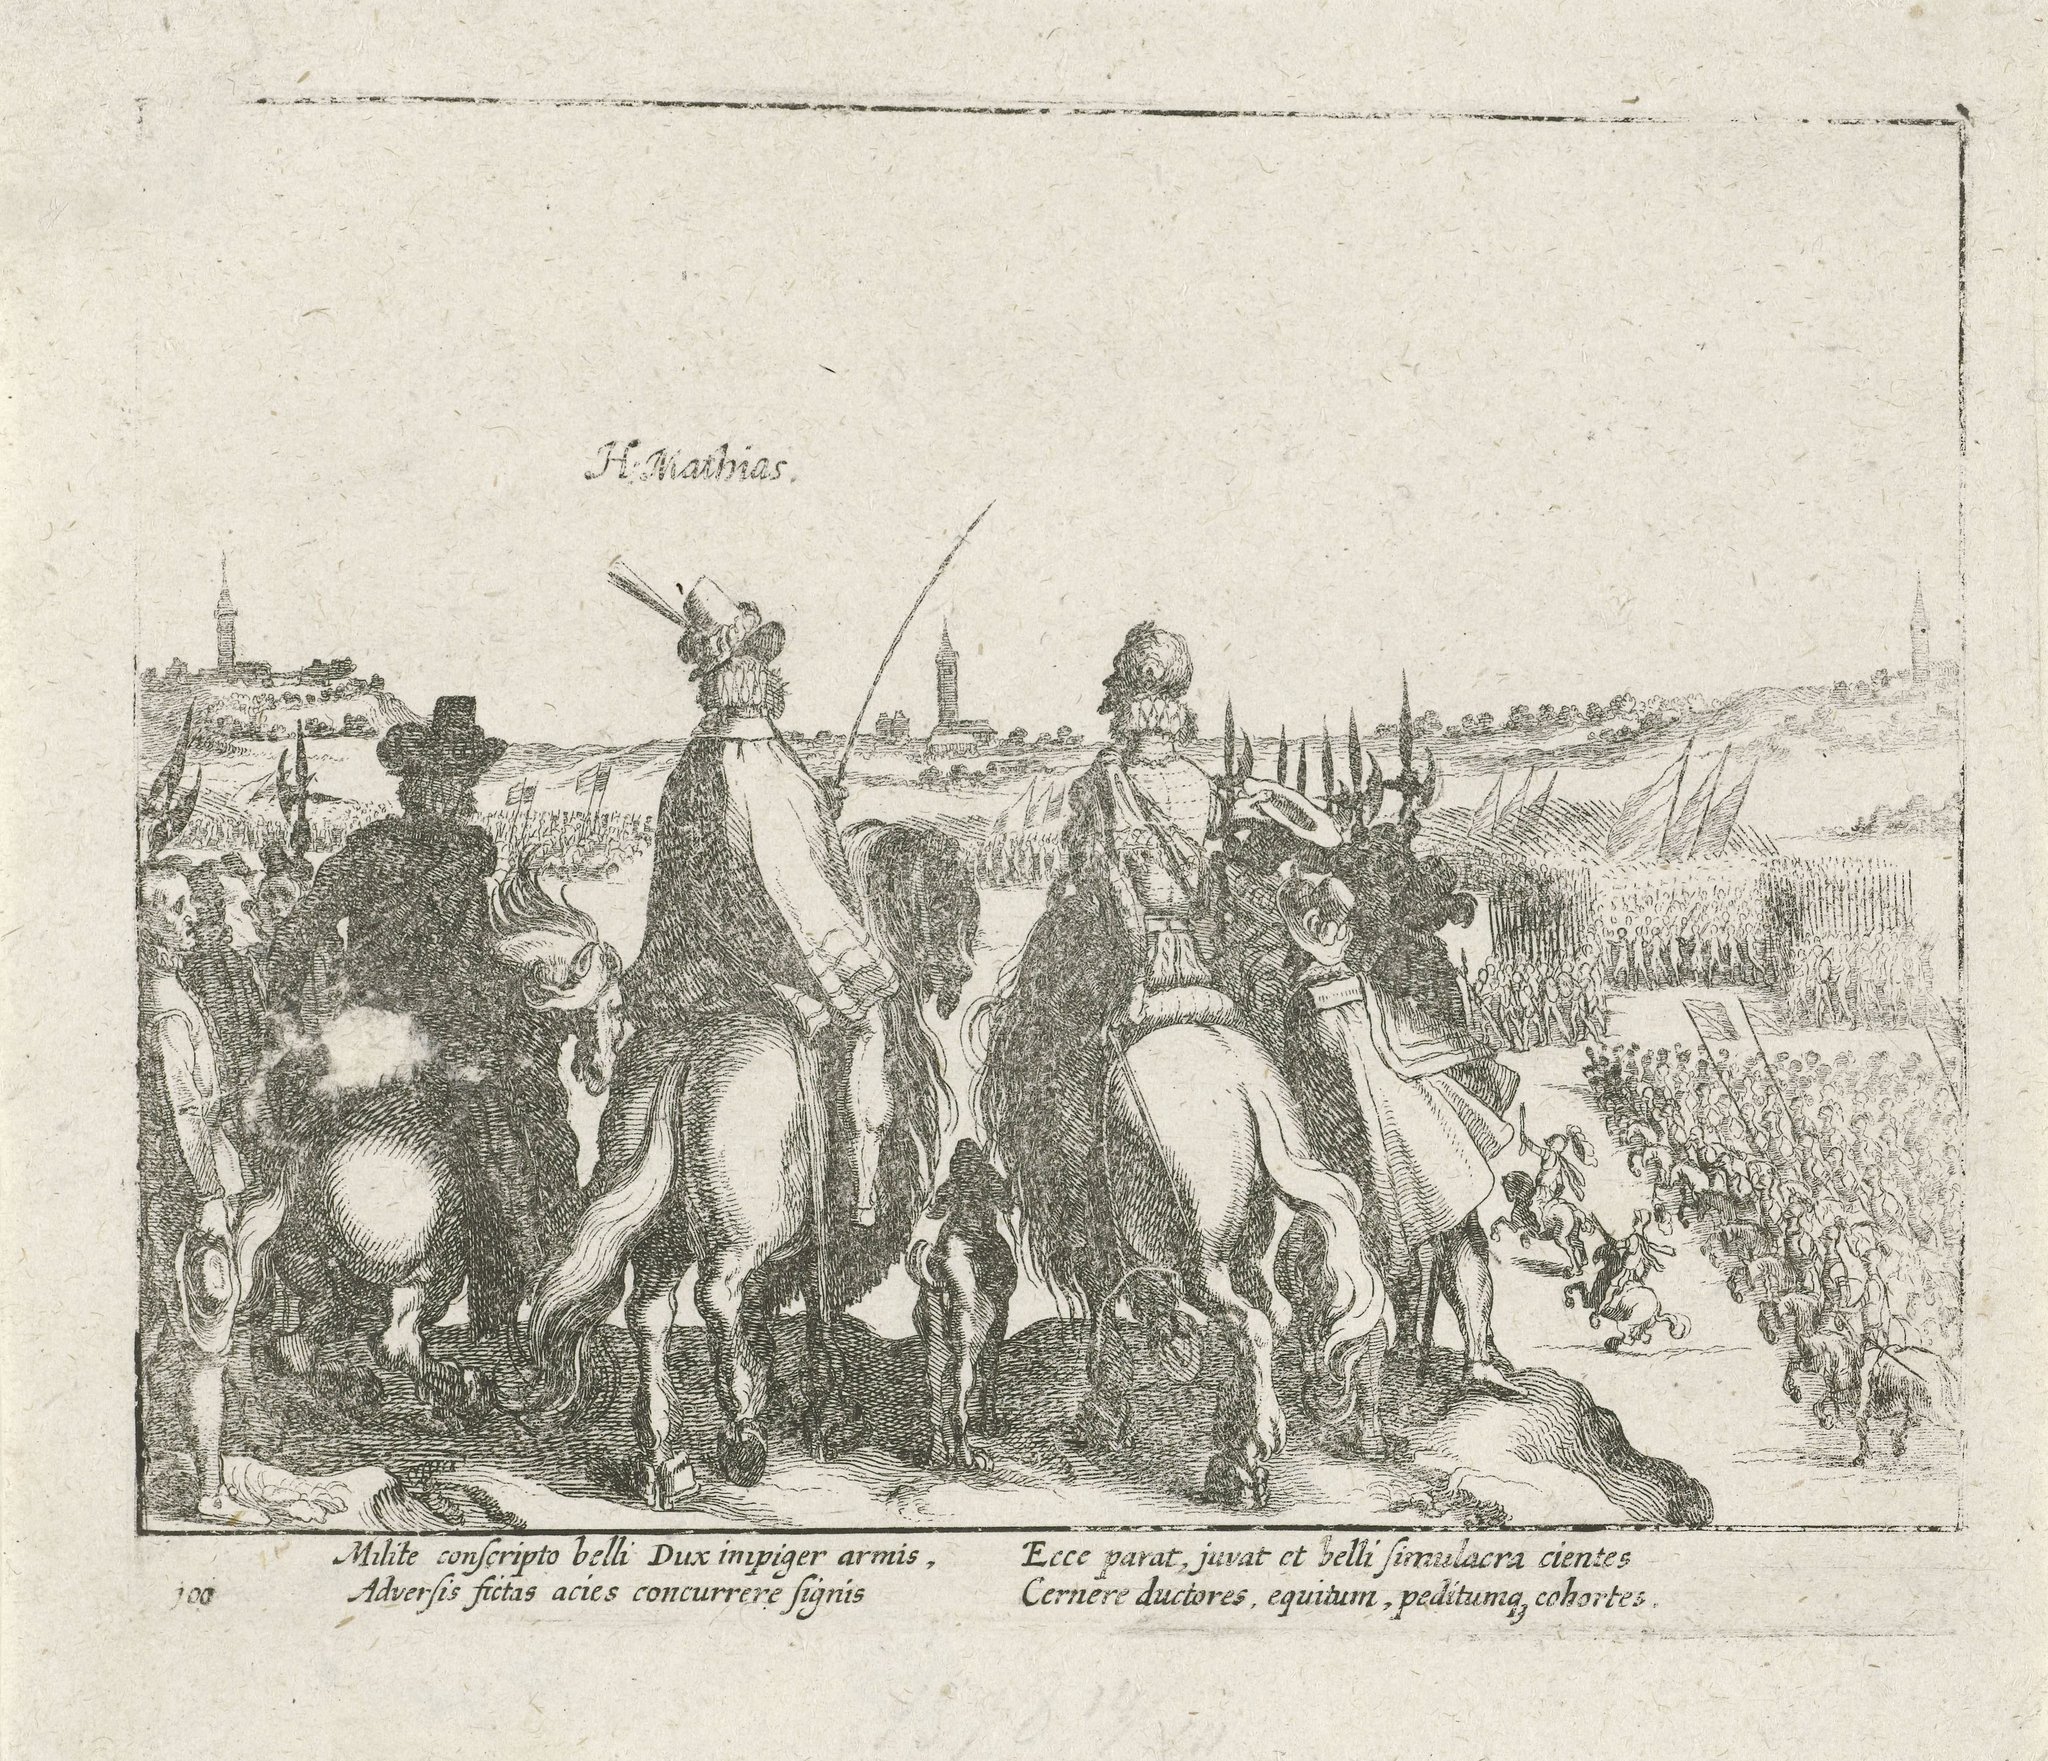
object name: history print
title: Matthias en de prins van Oranje houden revue over het Staatse leger, 1578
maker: simon frisius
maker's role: print maker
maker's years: 1570-1628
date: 1613-1615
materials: paper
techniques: etching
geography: northern netherlands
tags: vienna, matthias van oostenrijk (rooms-duits keizer), delft, william i (prince of orange), review, inspection (of company, unit, troop)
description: Aartshertog Matthias van Oostenrijk en de prins van Oranje houden revue over het Staatse leger in het veld gebracht tegen Don Juan, 14 juli 1578. De beide vorsten te paard, op de rug gezien. Met onderschrift van 4 regels in het Latijn. Genummerd: 100. Onbedrukt op achterzijde.